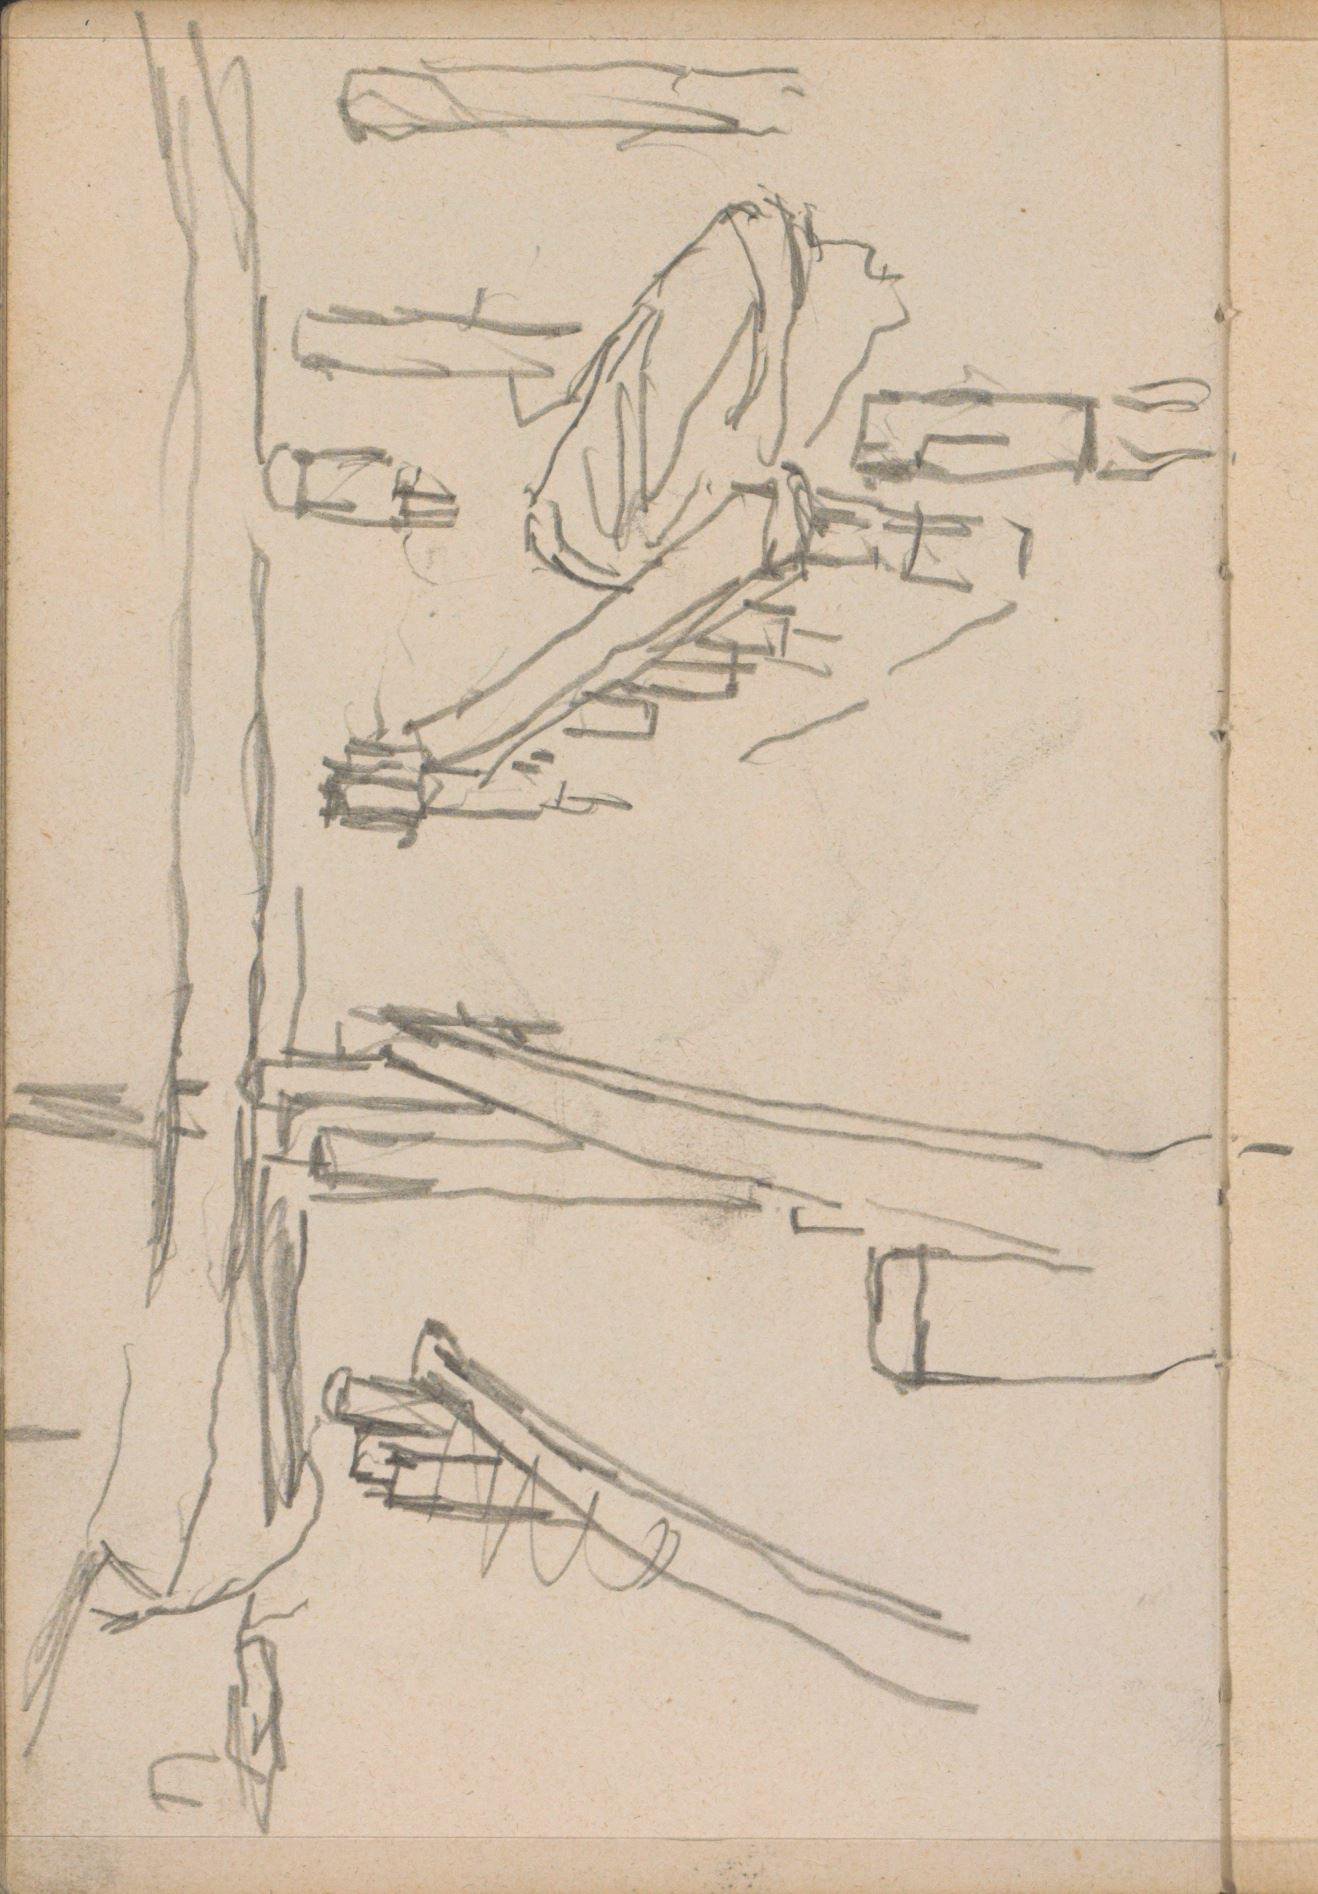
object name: sketchbook leaf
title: Gezicht op een aanlegplaats voor boten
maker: george hendrik breitner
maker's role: draughtsman, painter, print maker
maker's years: 1857-1923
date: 1907-1909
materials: paper, pencil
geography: ghent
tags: rowing-boat, canoe, etc., pier, quay, wharf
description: Gezicht op een aanlegplaats voor boten. Rechts een roeiboot. Pagina 15 uit een schetsboek met 46 bladen vervaardigd te Antwerpen, Gent en Amsterdam.